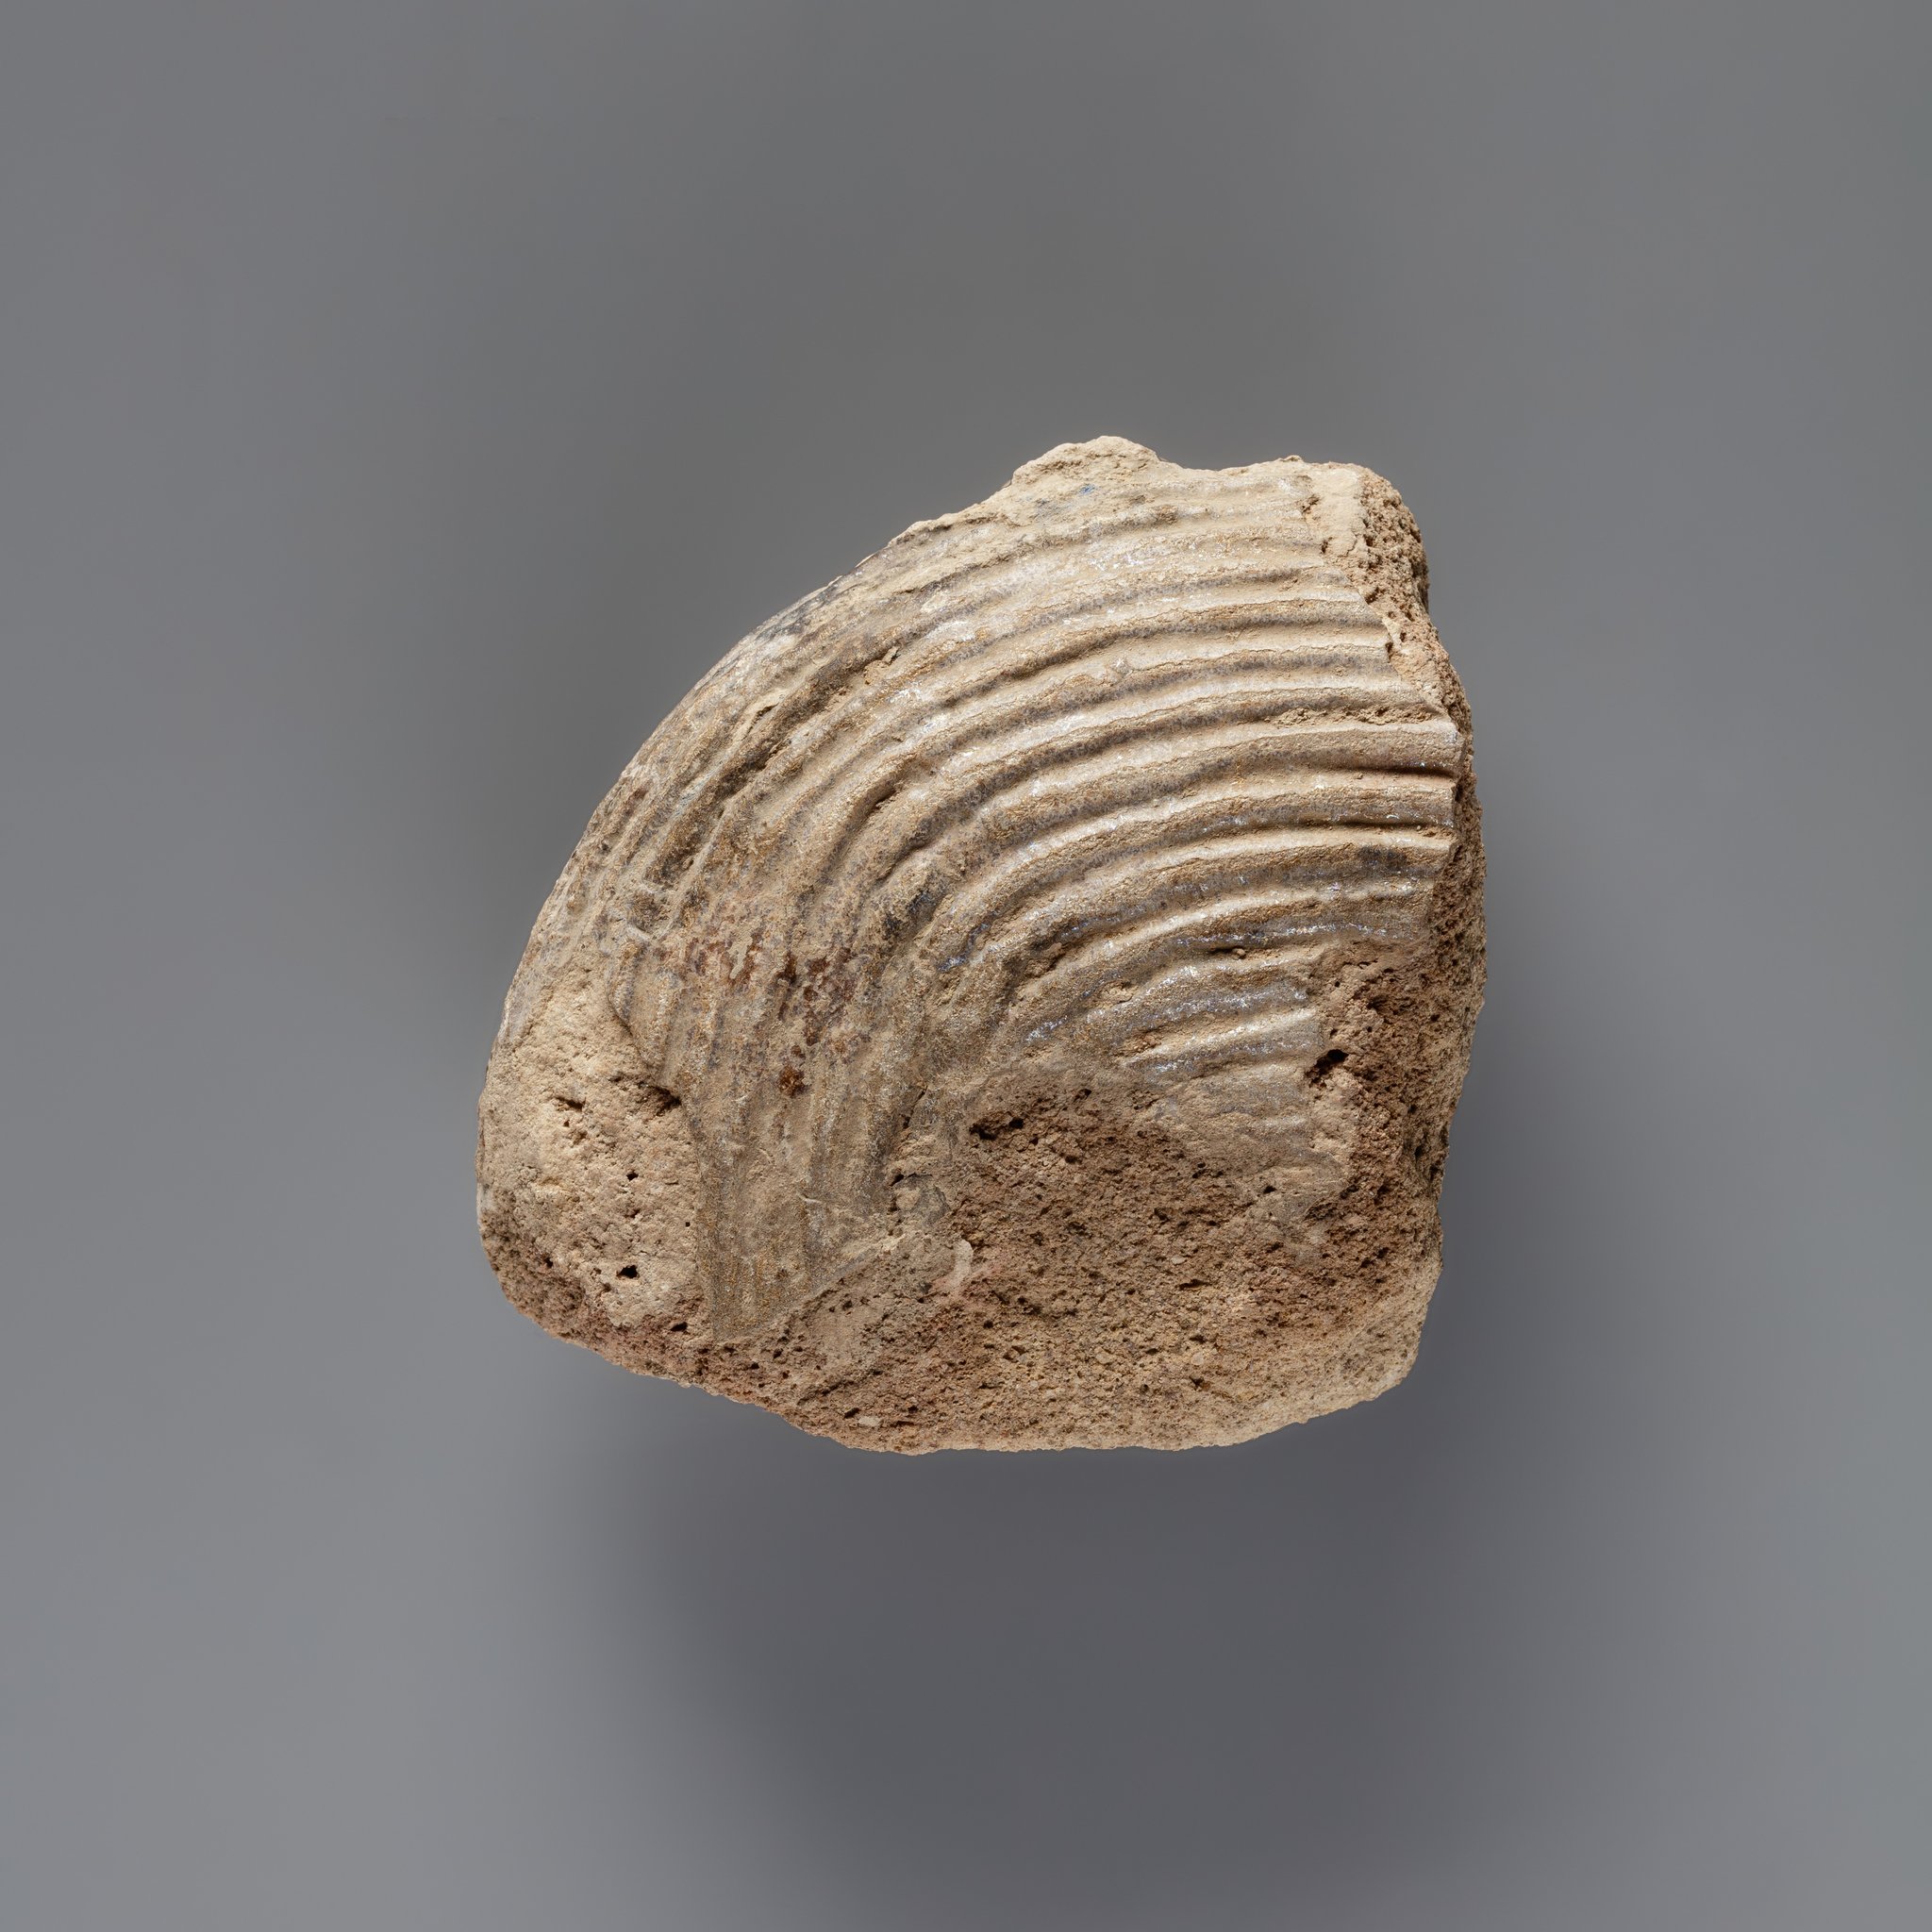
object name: tile inlay, palace of ramesses ii, foreigner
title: Tile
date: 1279-1213 BCE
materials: faience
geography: egypt